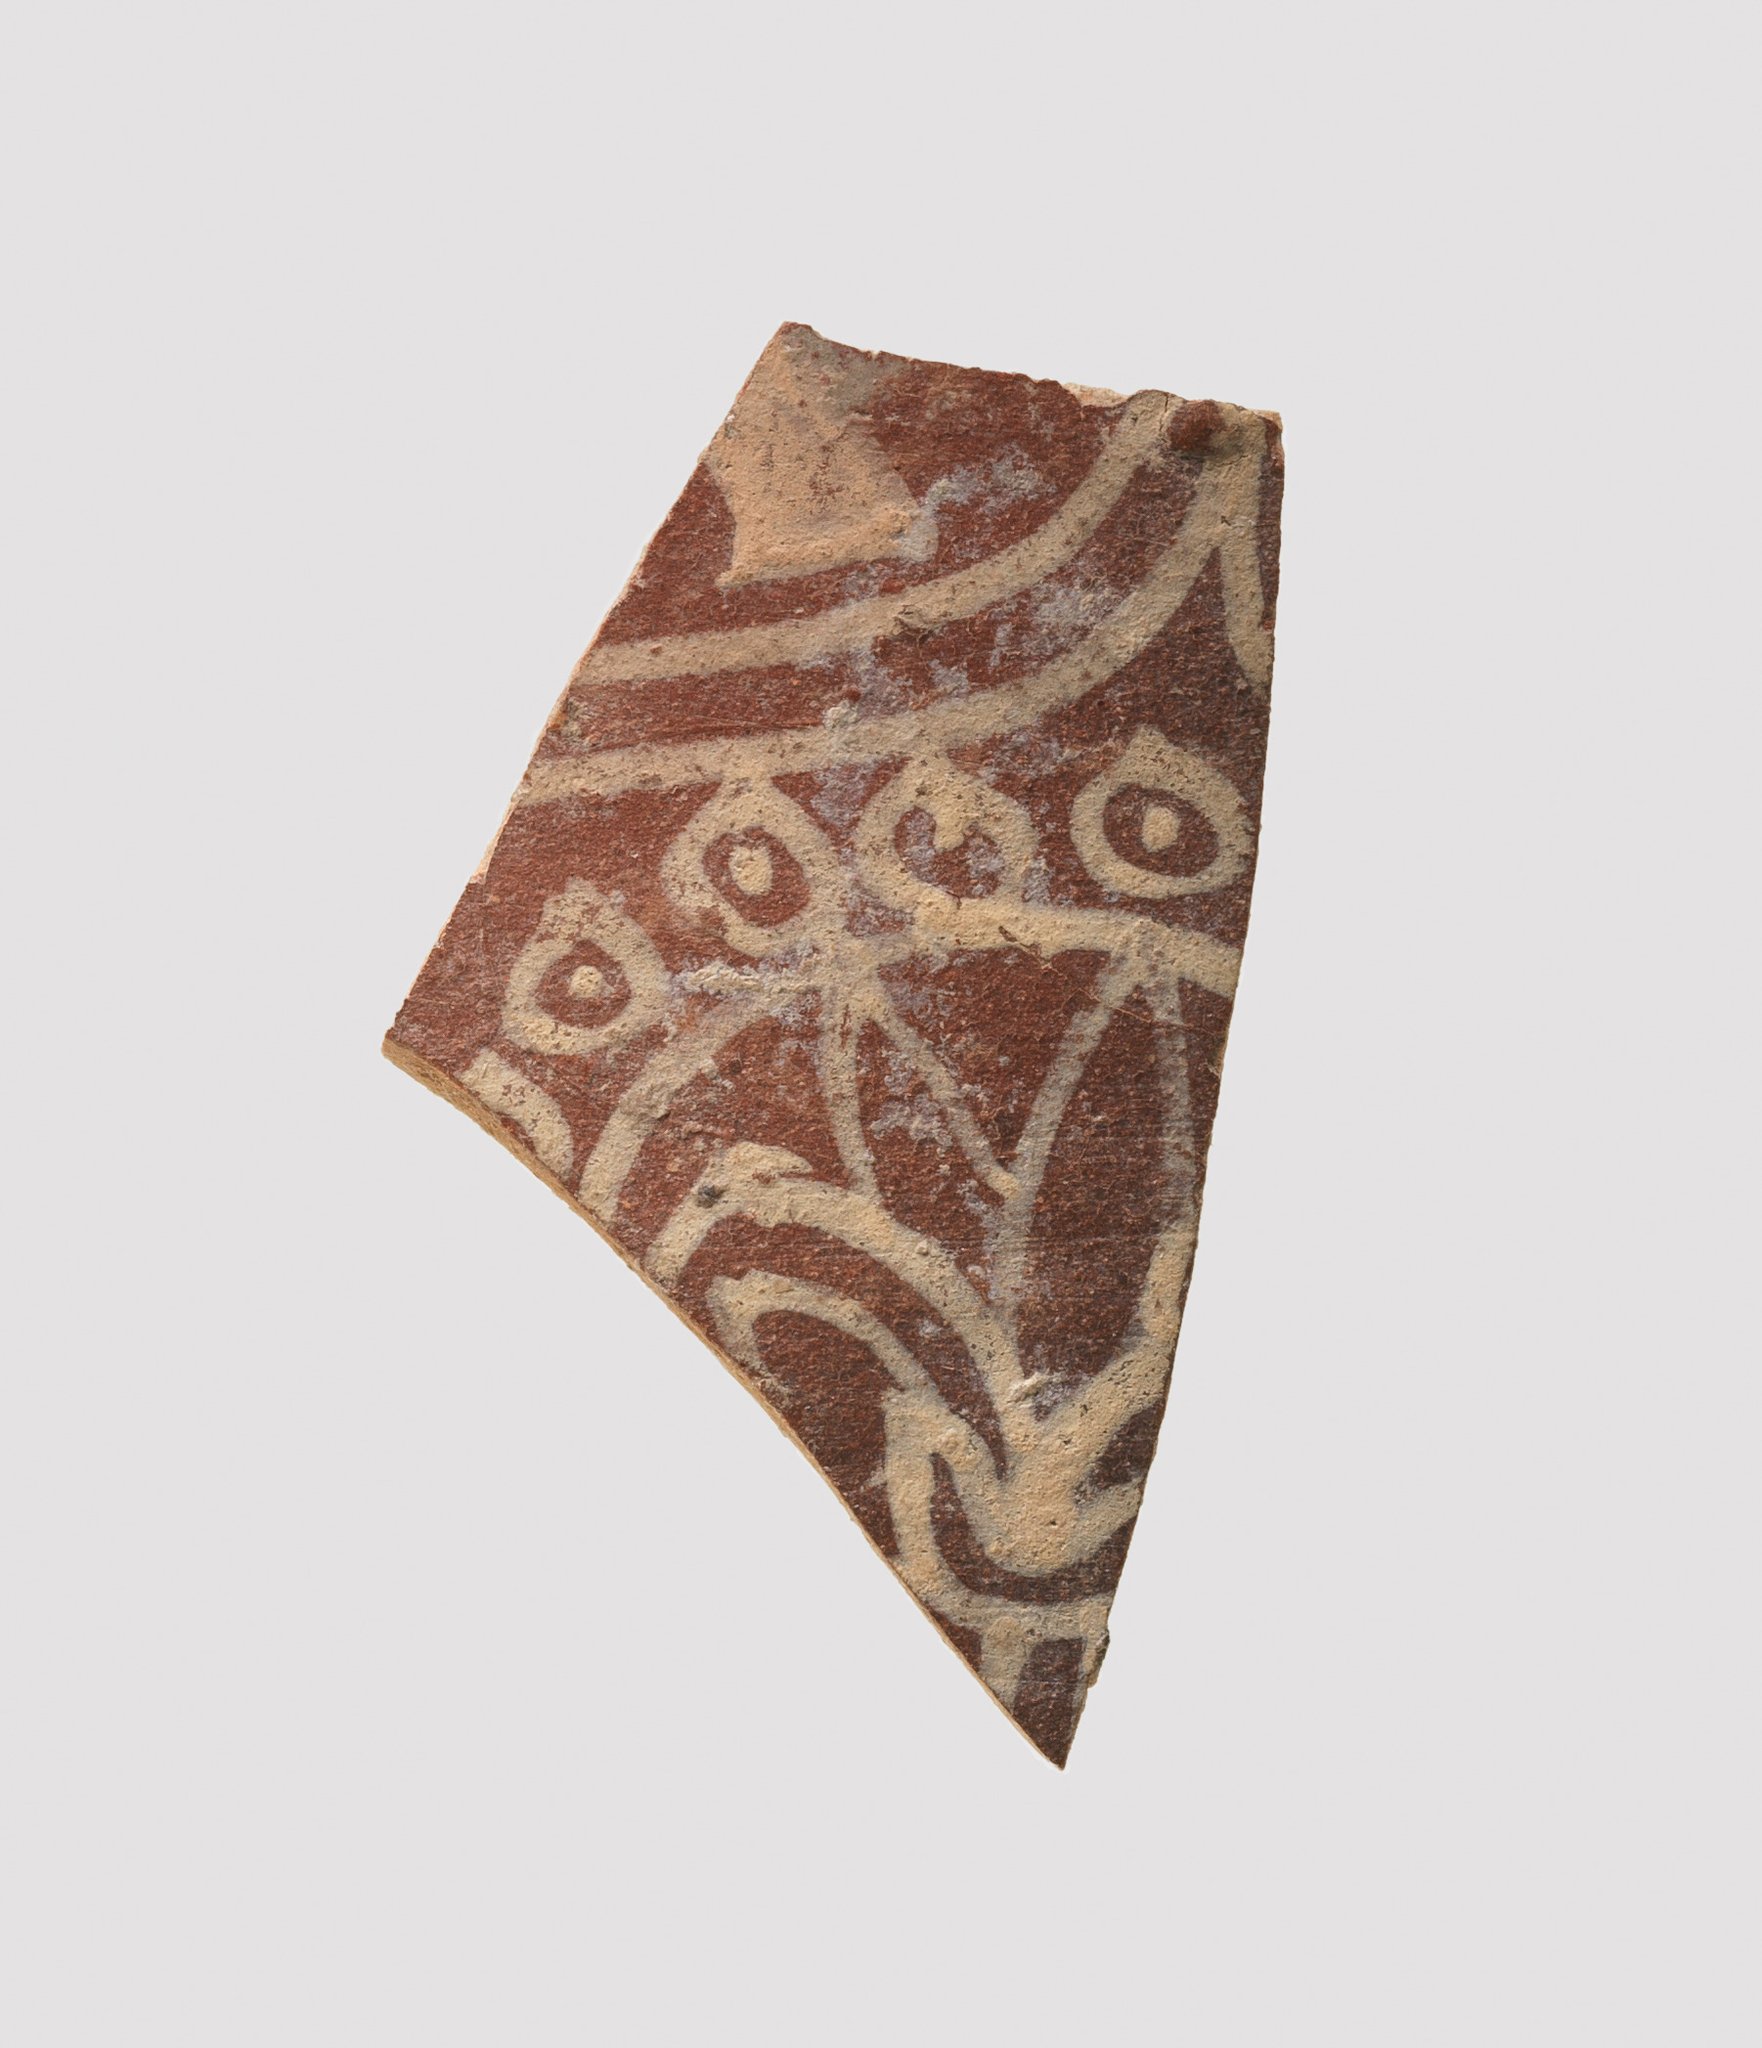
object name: sherd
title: Nuzi ware sherd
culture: mitanni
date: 1500-1201 BCE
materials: ceramic, paint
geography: mesopotamia